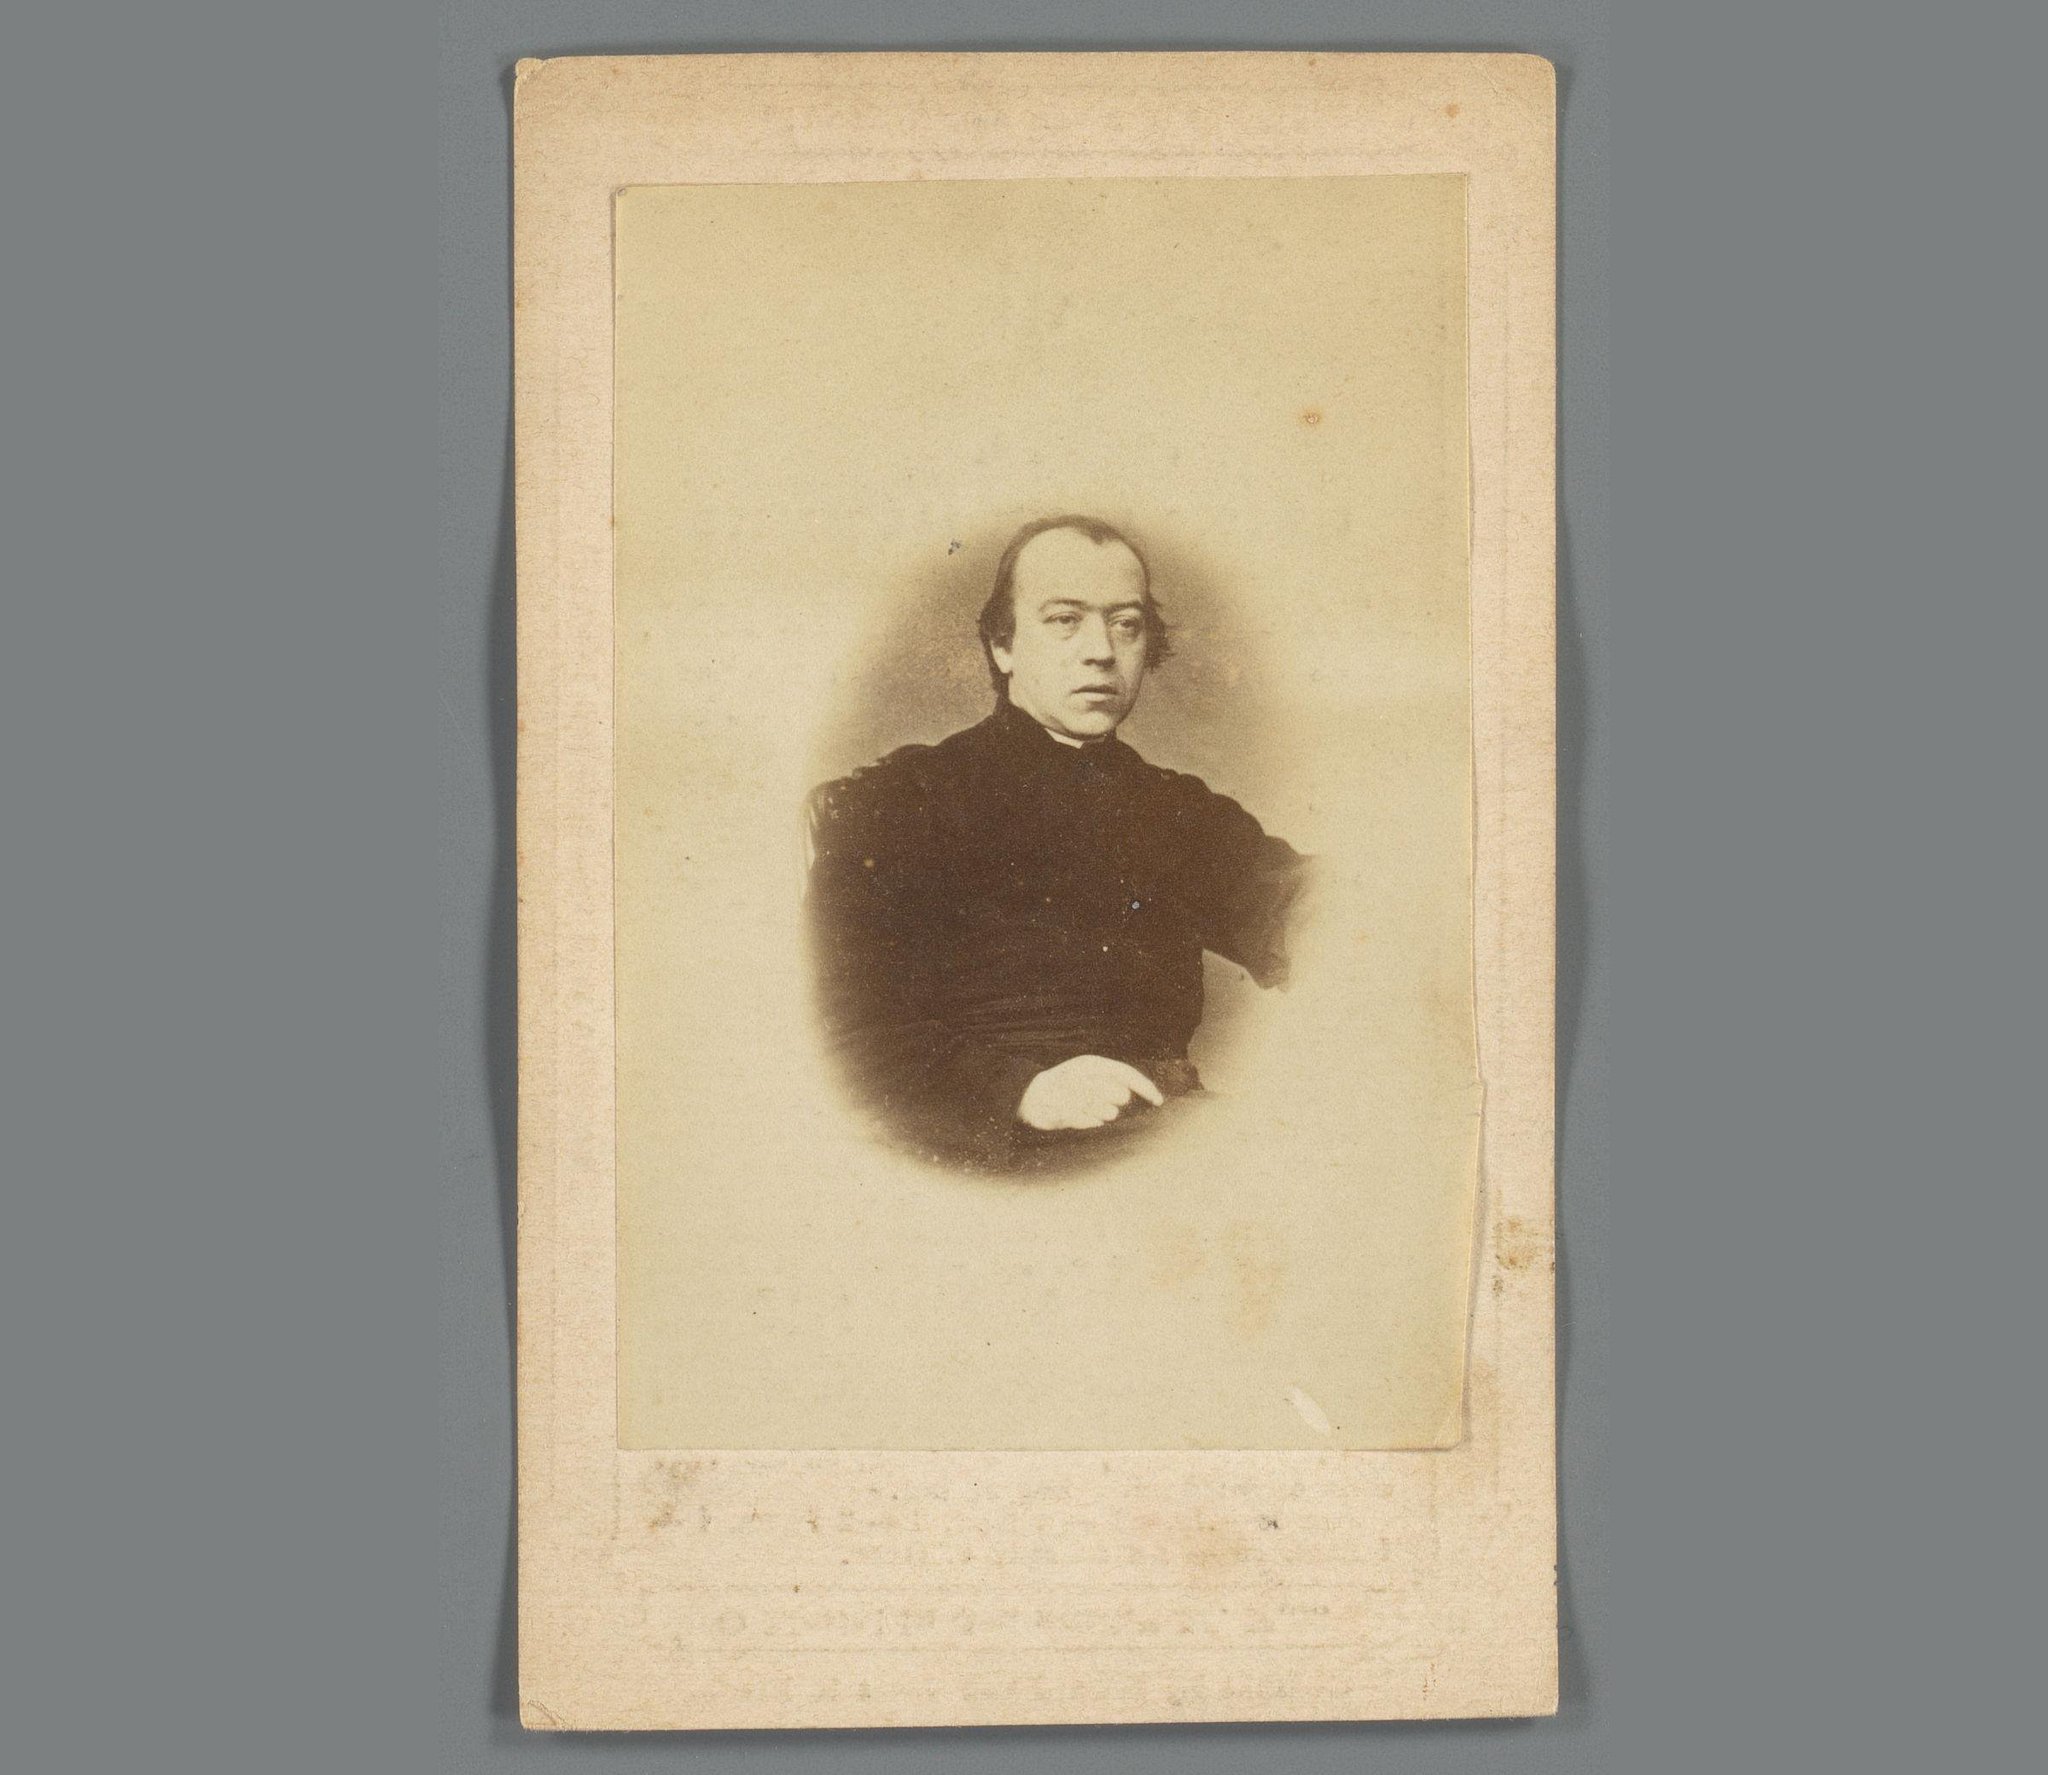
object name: prayer card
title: Portret van Mattheus Feijen op bidprent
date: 1872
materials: paper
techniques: albumen print, letterpress printing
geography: breda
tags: bergen op zoom, priest, priest (roman catholic), historical persons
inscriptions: inscription: ‘In het uur van onzen dood!"/ Jesus, Maria, Joseph. (...) Gedrukt bij Eduard van Wees in Breda.’